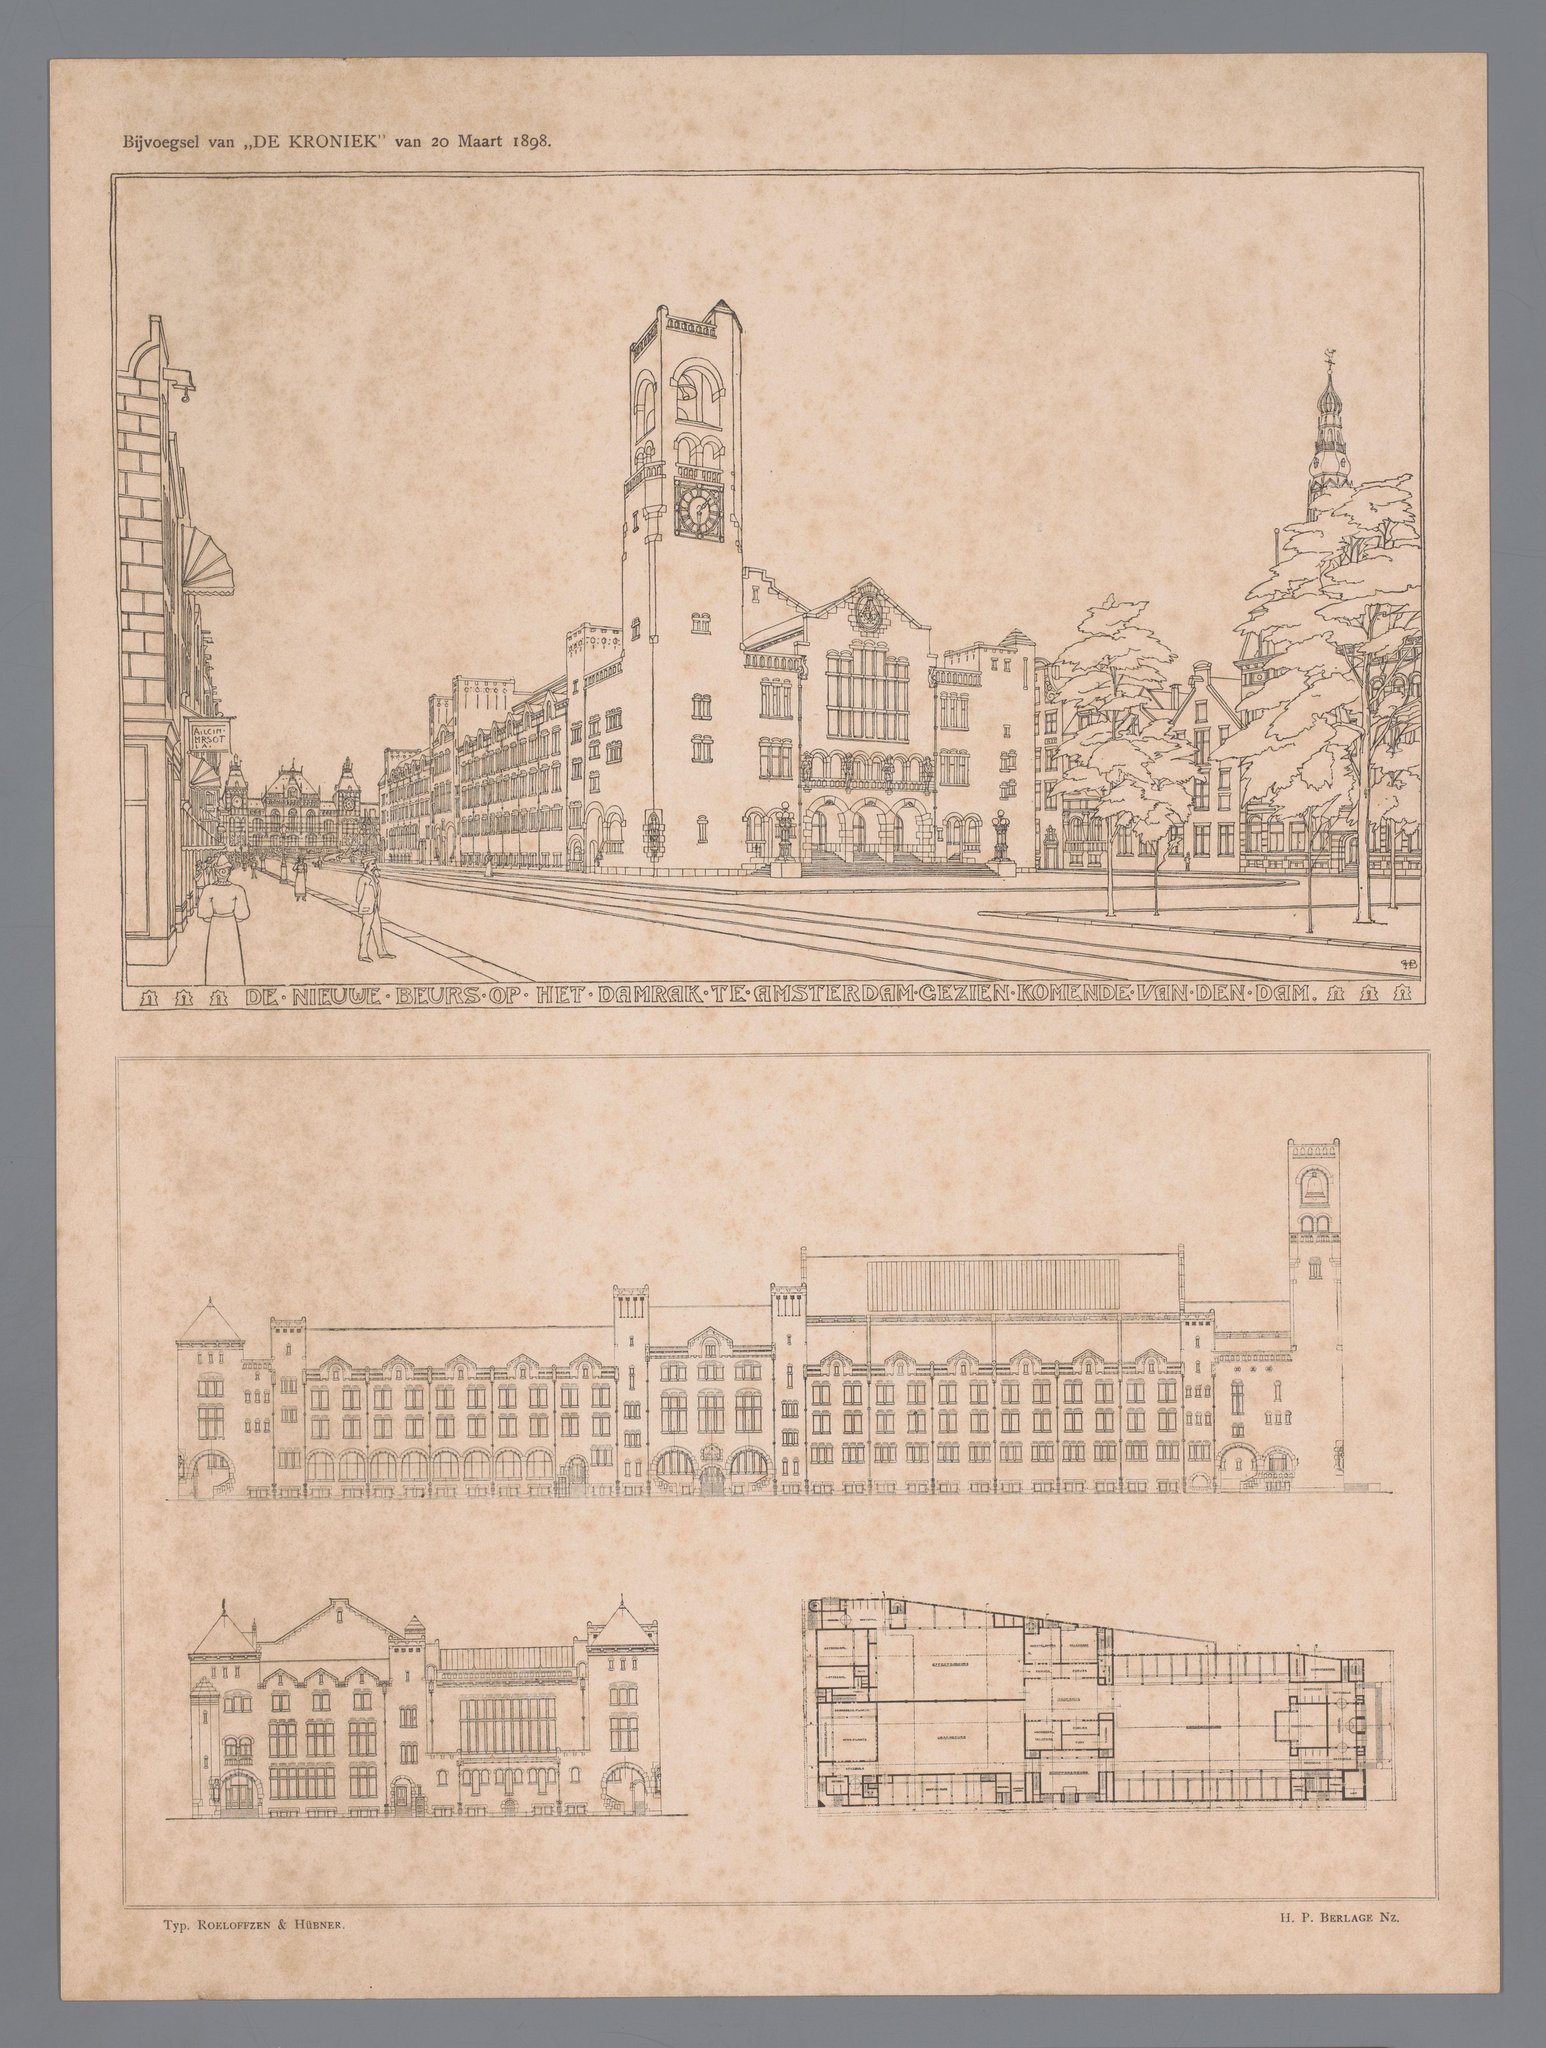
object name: print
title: De Nieuwe Beurs op het Damrak te Amsterdam gezien komende van den Dam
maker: hendrik petrus berlage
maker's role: draughtsman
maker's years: 1856-1934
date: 1898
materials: paper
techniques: lithograph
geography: amsterdam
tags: stock exchange, stock-market, architectural design or model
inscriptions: date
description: Prent met titel en onderschrift, bijvoegsel bij 'De Kroniek'. Gesigneerd en gedateerd.